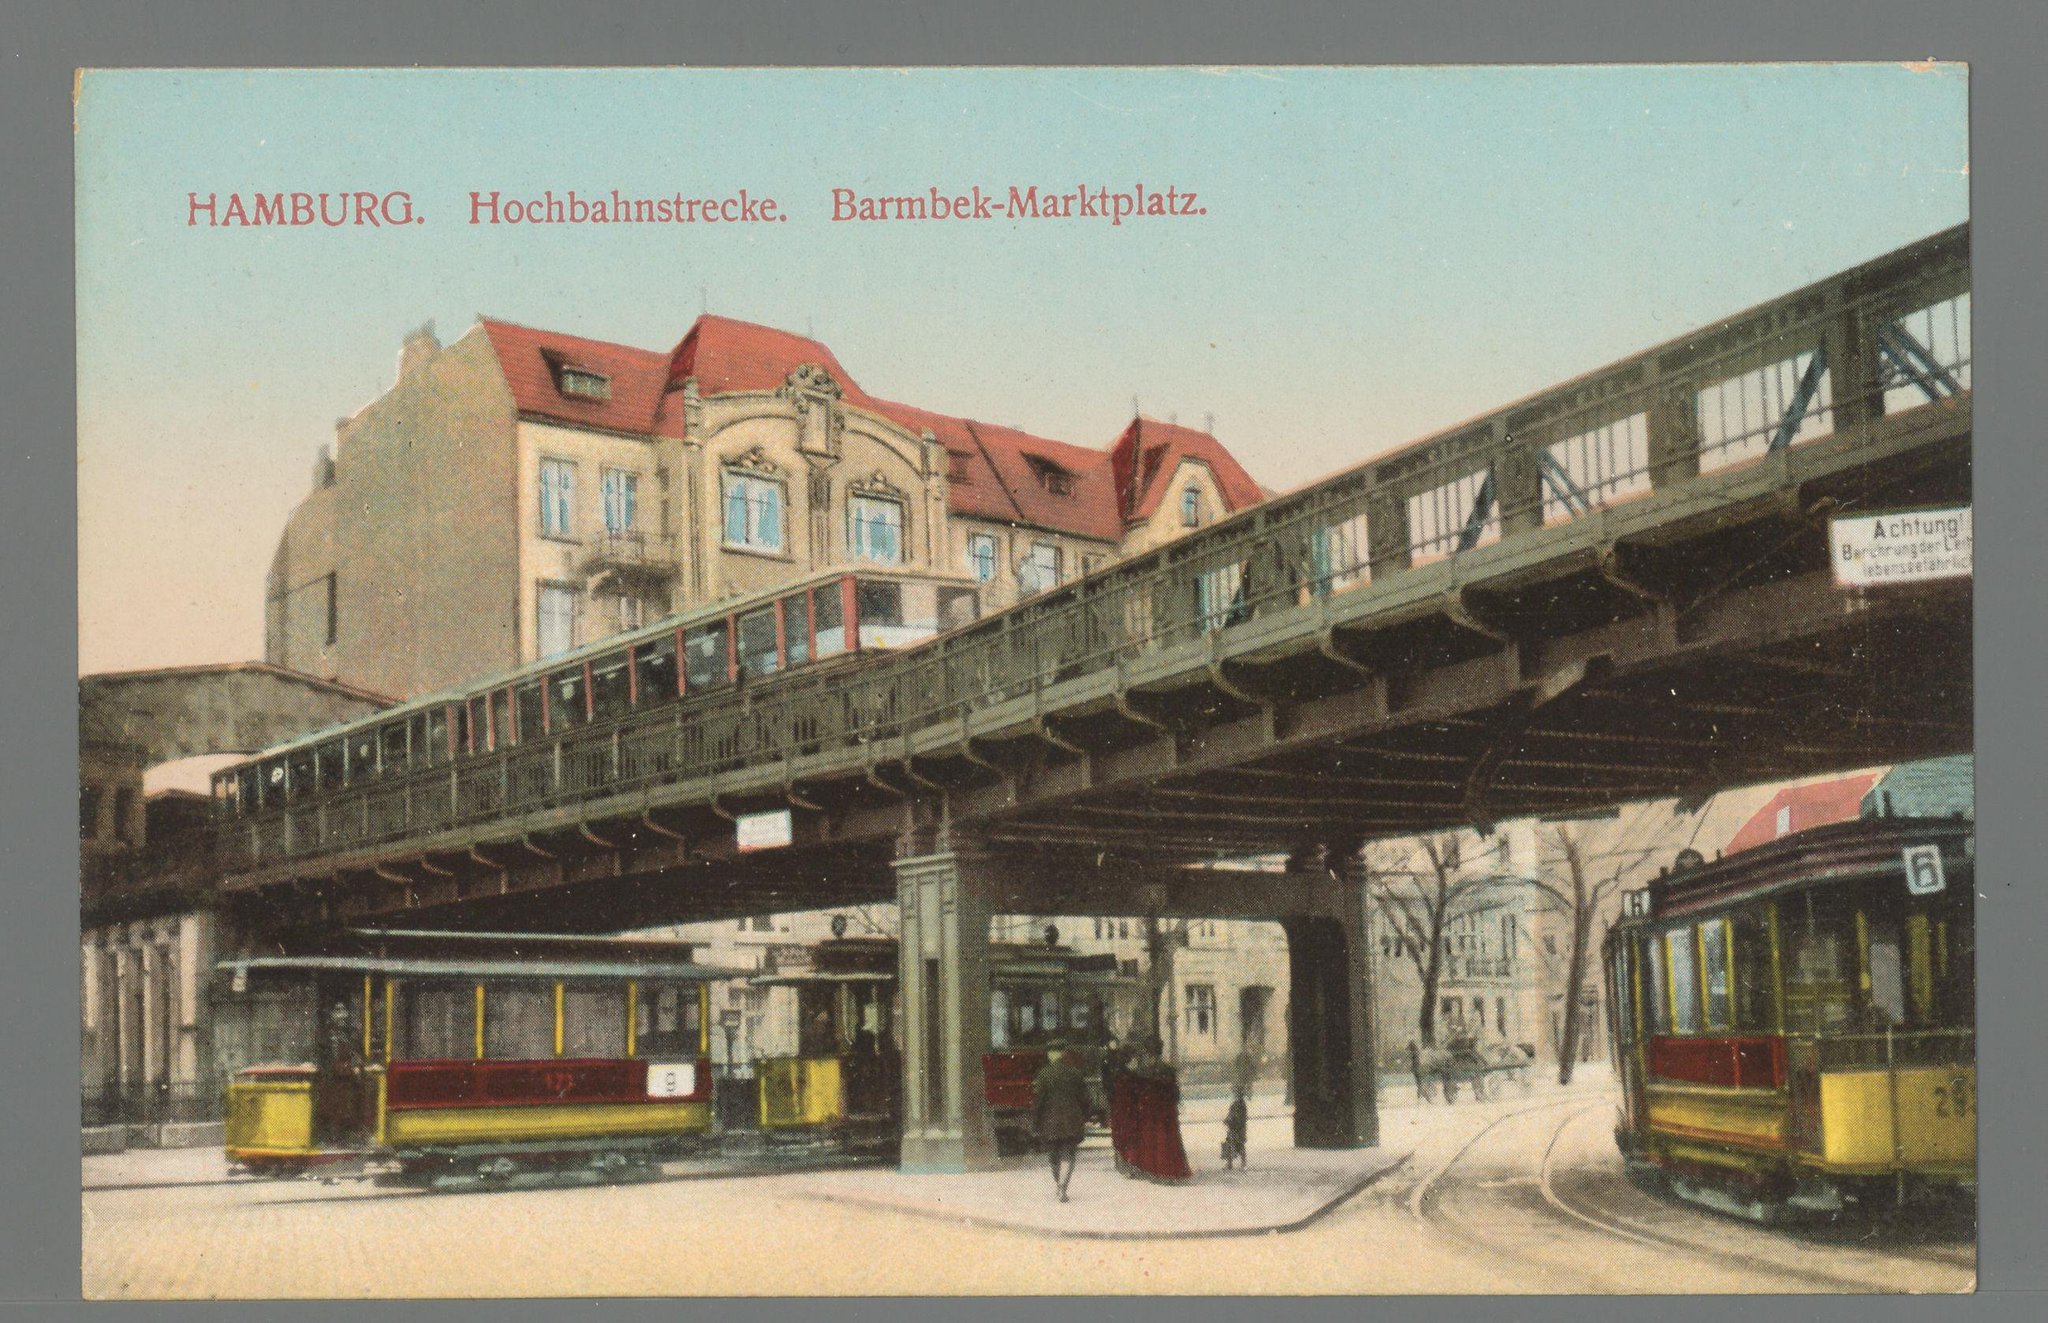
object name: photomechanical print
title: Hamburg. Hochbahnstrecke. Barmbek-Marktplatz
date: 1905-1930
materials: cardboard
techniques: lithograph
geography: hamburg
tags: tram, passenger train, bridge in city across river, canal, etc.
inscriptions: monogram: ‘H.H.H.’